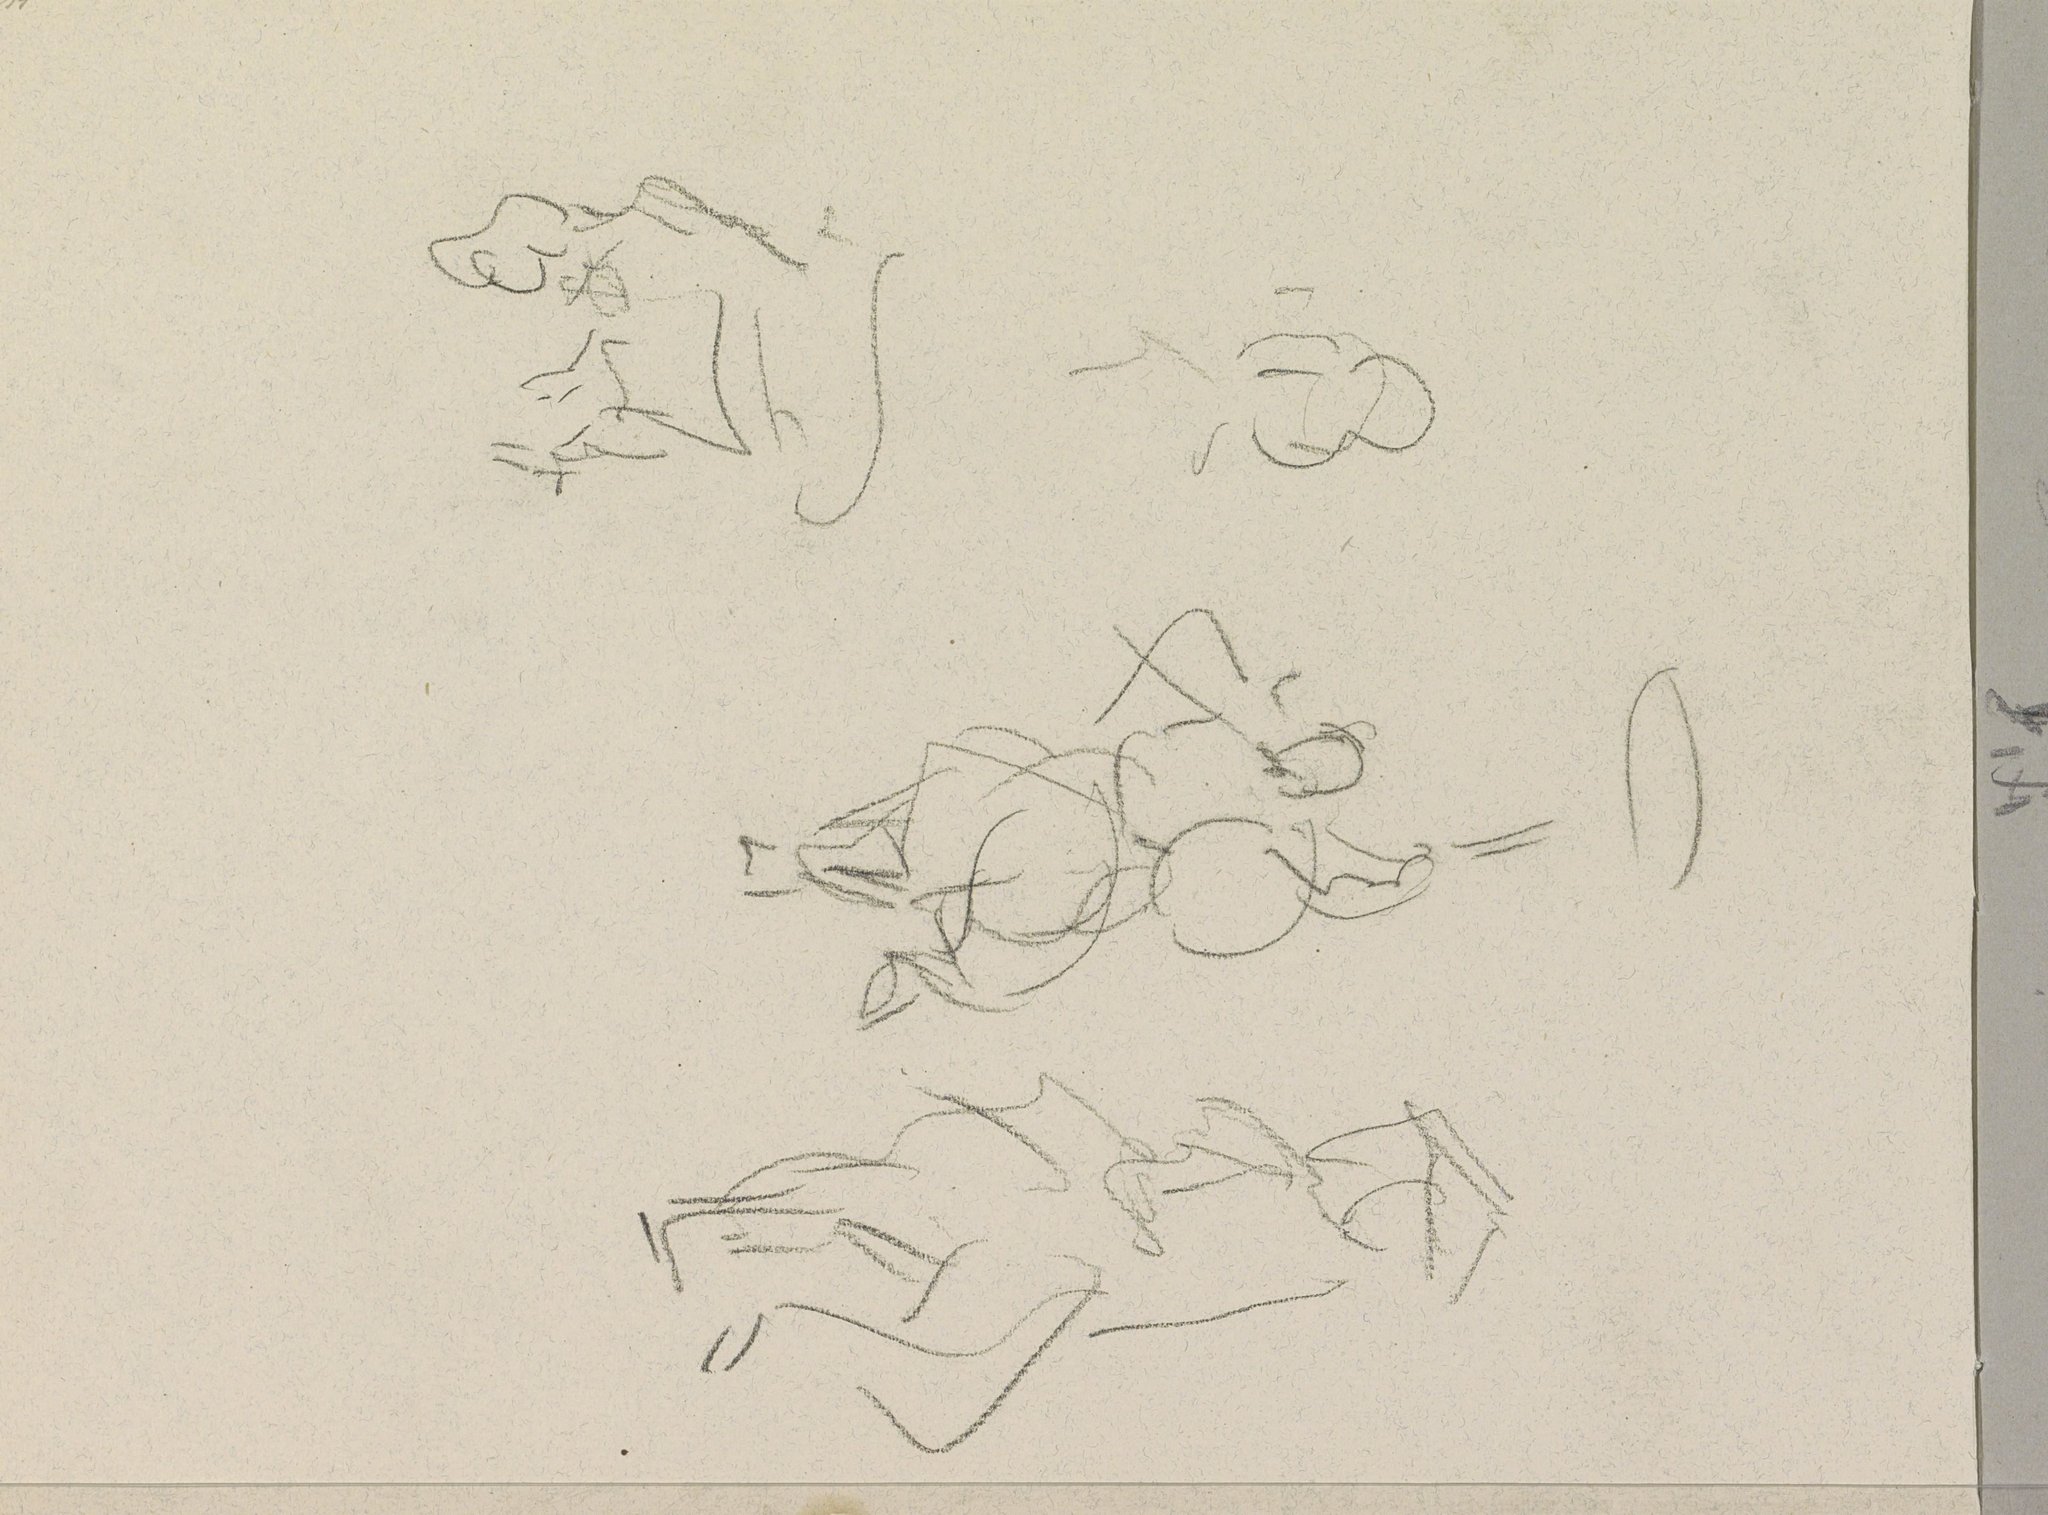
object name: sketchbook leaf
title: Studieblad met Japanse figuren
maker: isaac israels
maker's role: draughtsman, painter, print maker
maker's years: 1865-1934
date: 1875-1934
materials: chalk, paper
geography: the hague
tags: adult man, japanese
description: Blad 7 verso uit schetsboek IV met 27 bladen.